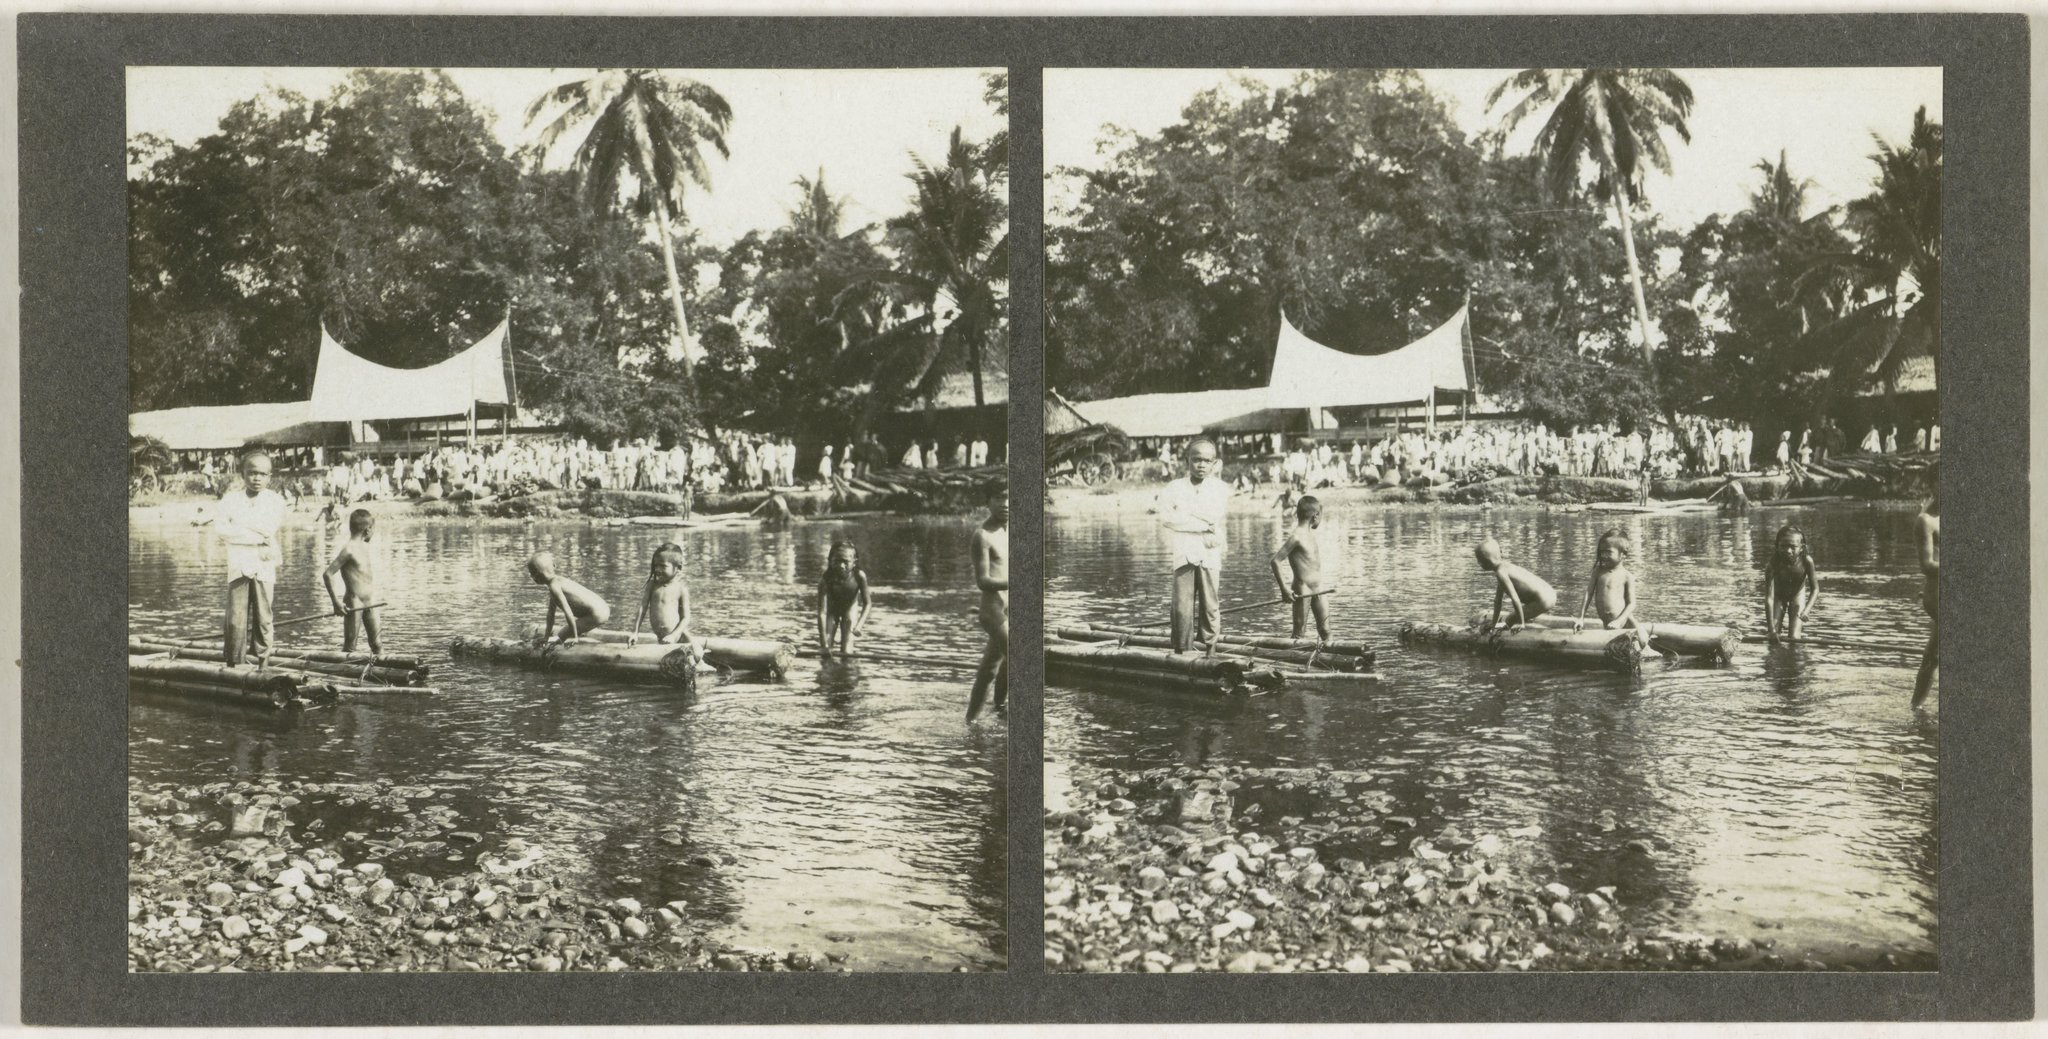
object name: stereograph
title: Kinderen in het water tijdens een bijeenkomst in Padang, Sumatra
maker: Anonymous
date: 1900-1940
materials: paper, cardboard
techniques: gelatin silver print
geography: padang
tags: (playing with) boats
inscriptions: inscription: ‘S. Westkust/ Overvaart ajer hadji.’